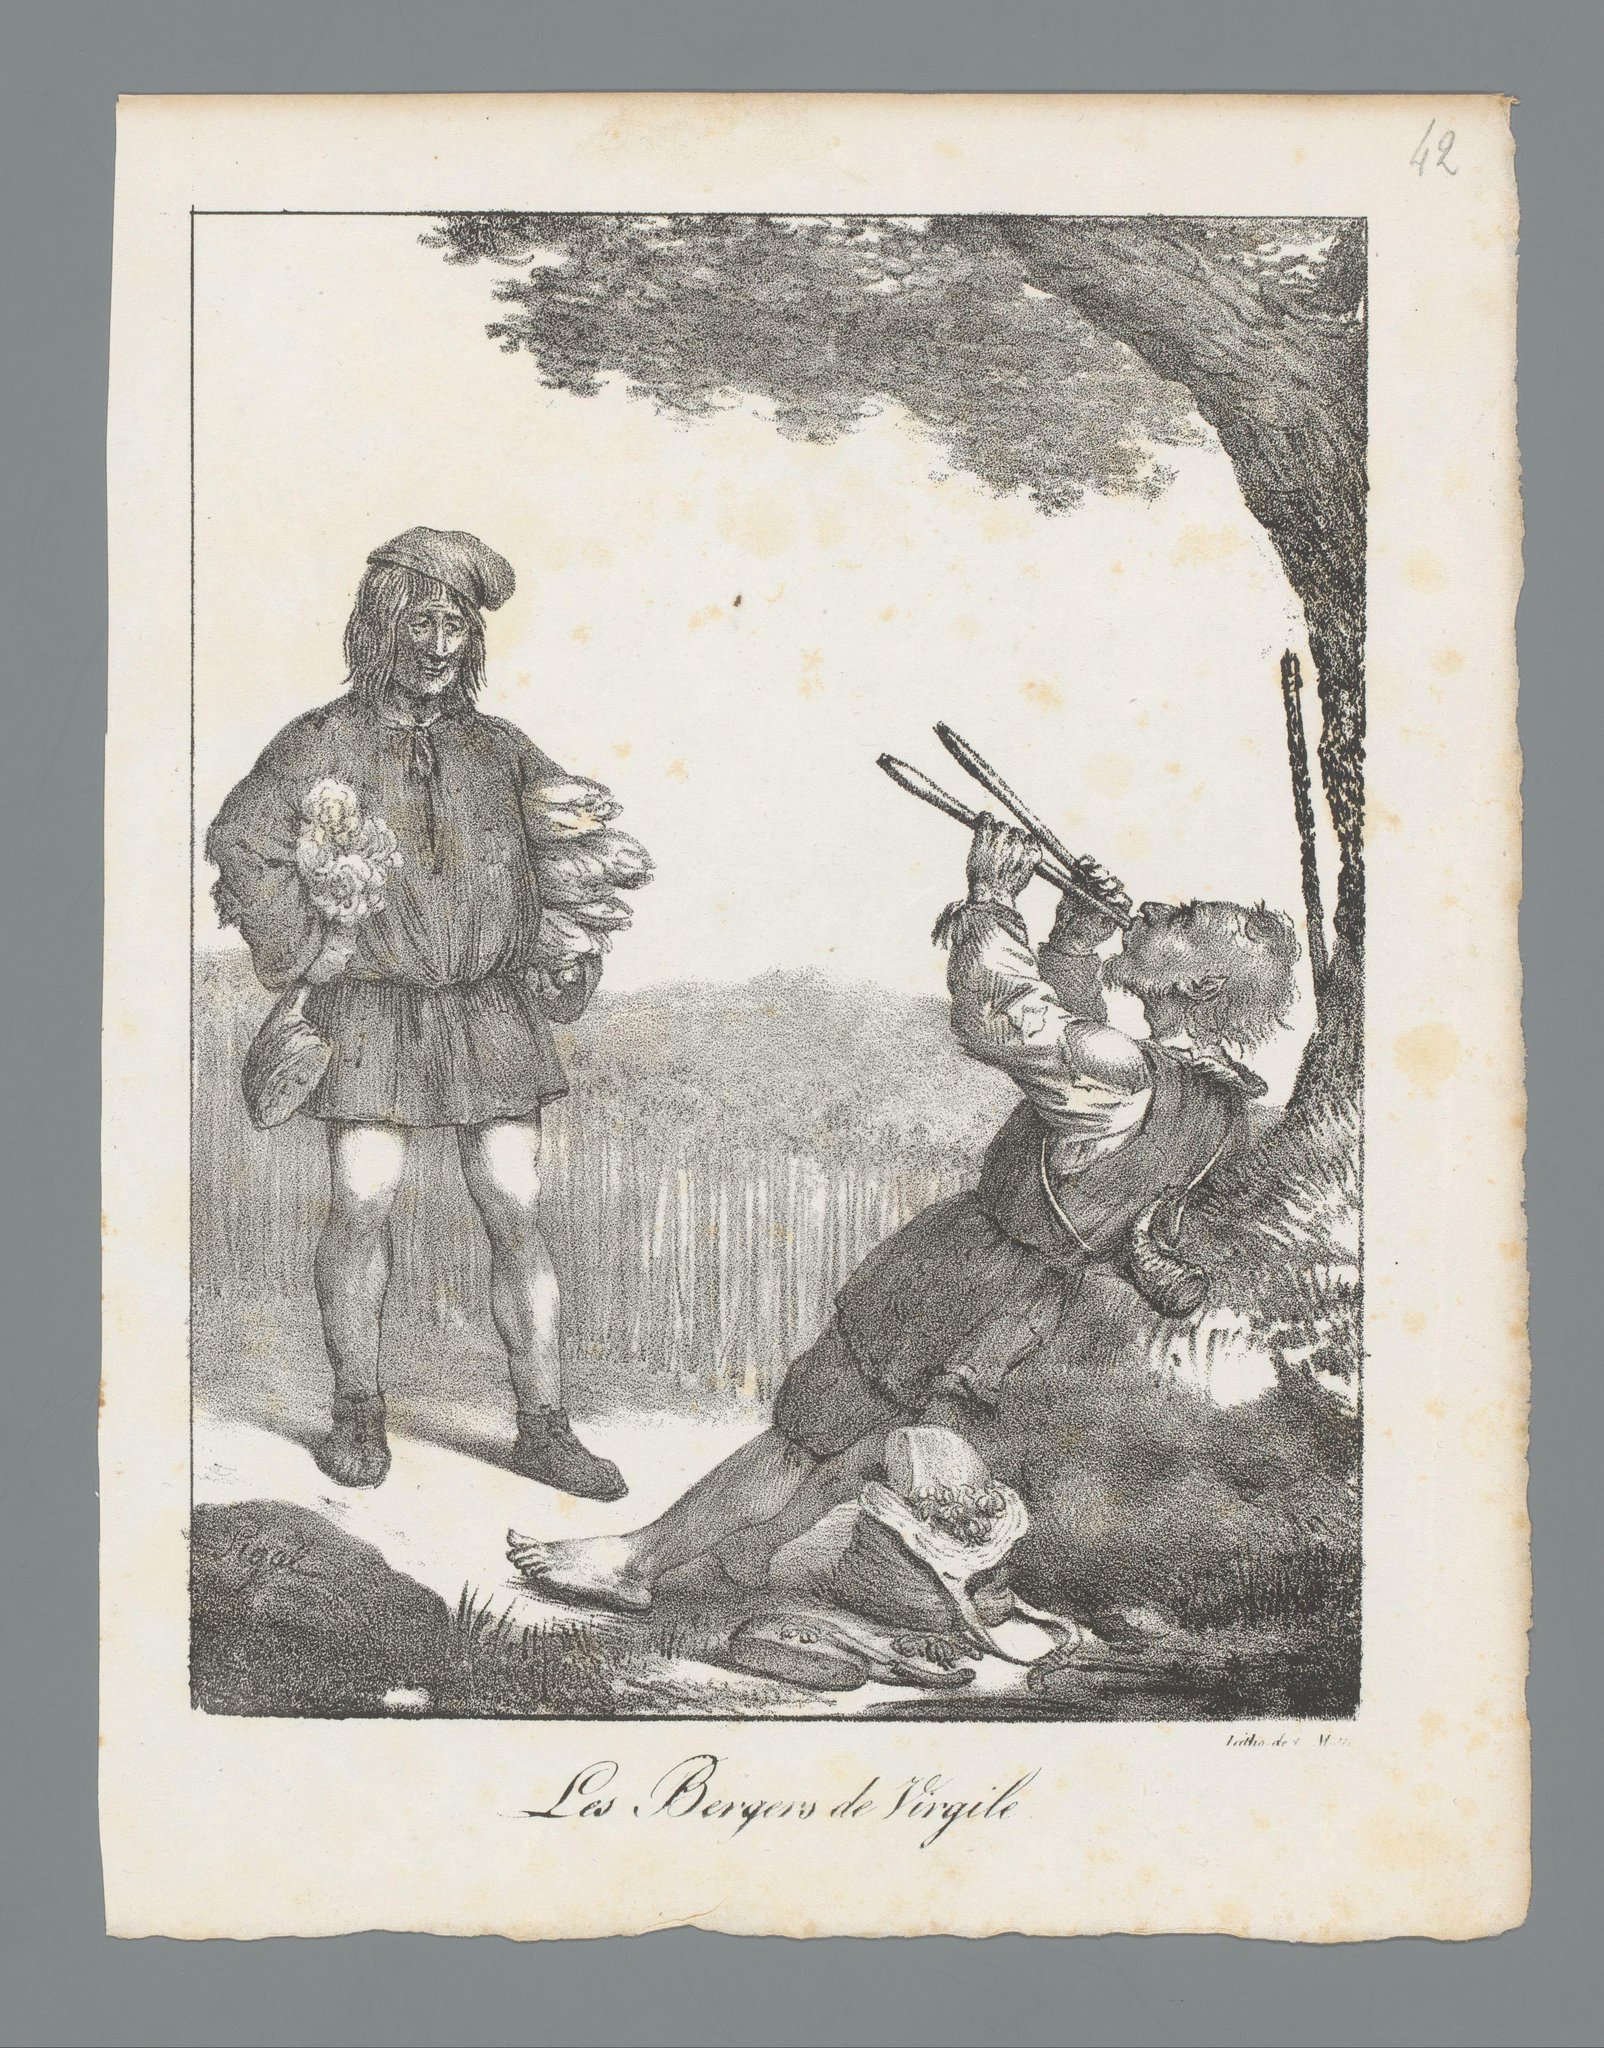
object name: print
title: Les bergers de Virgile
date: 1823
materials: paper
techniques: lithograph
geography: paris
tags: herding, herdsman, herdswoman, shepherd, shepherdess, cowherd, etc.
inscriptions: collector's mark: Lugt 2228